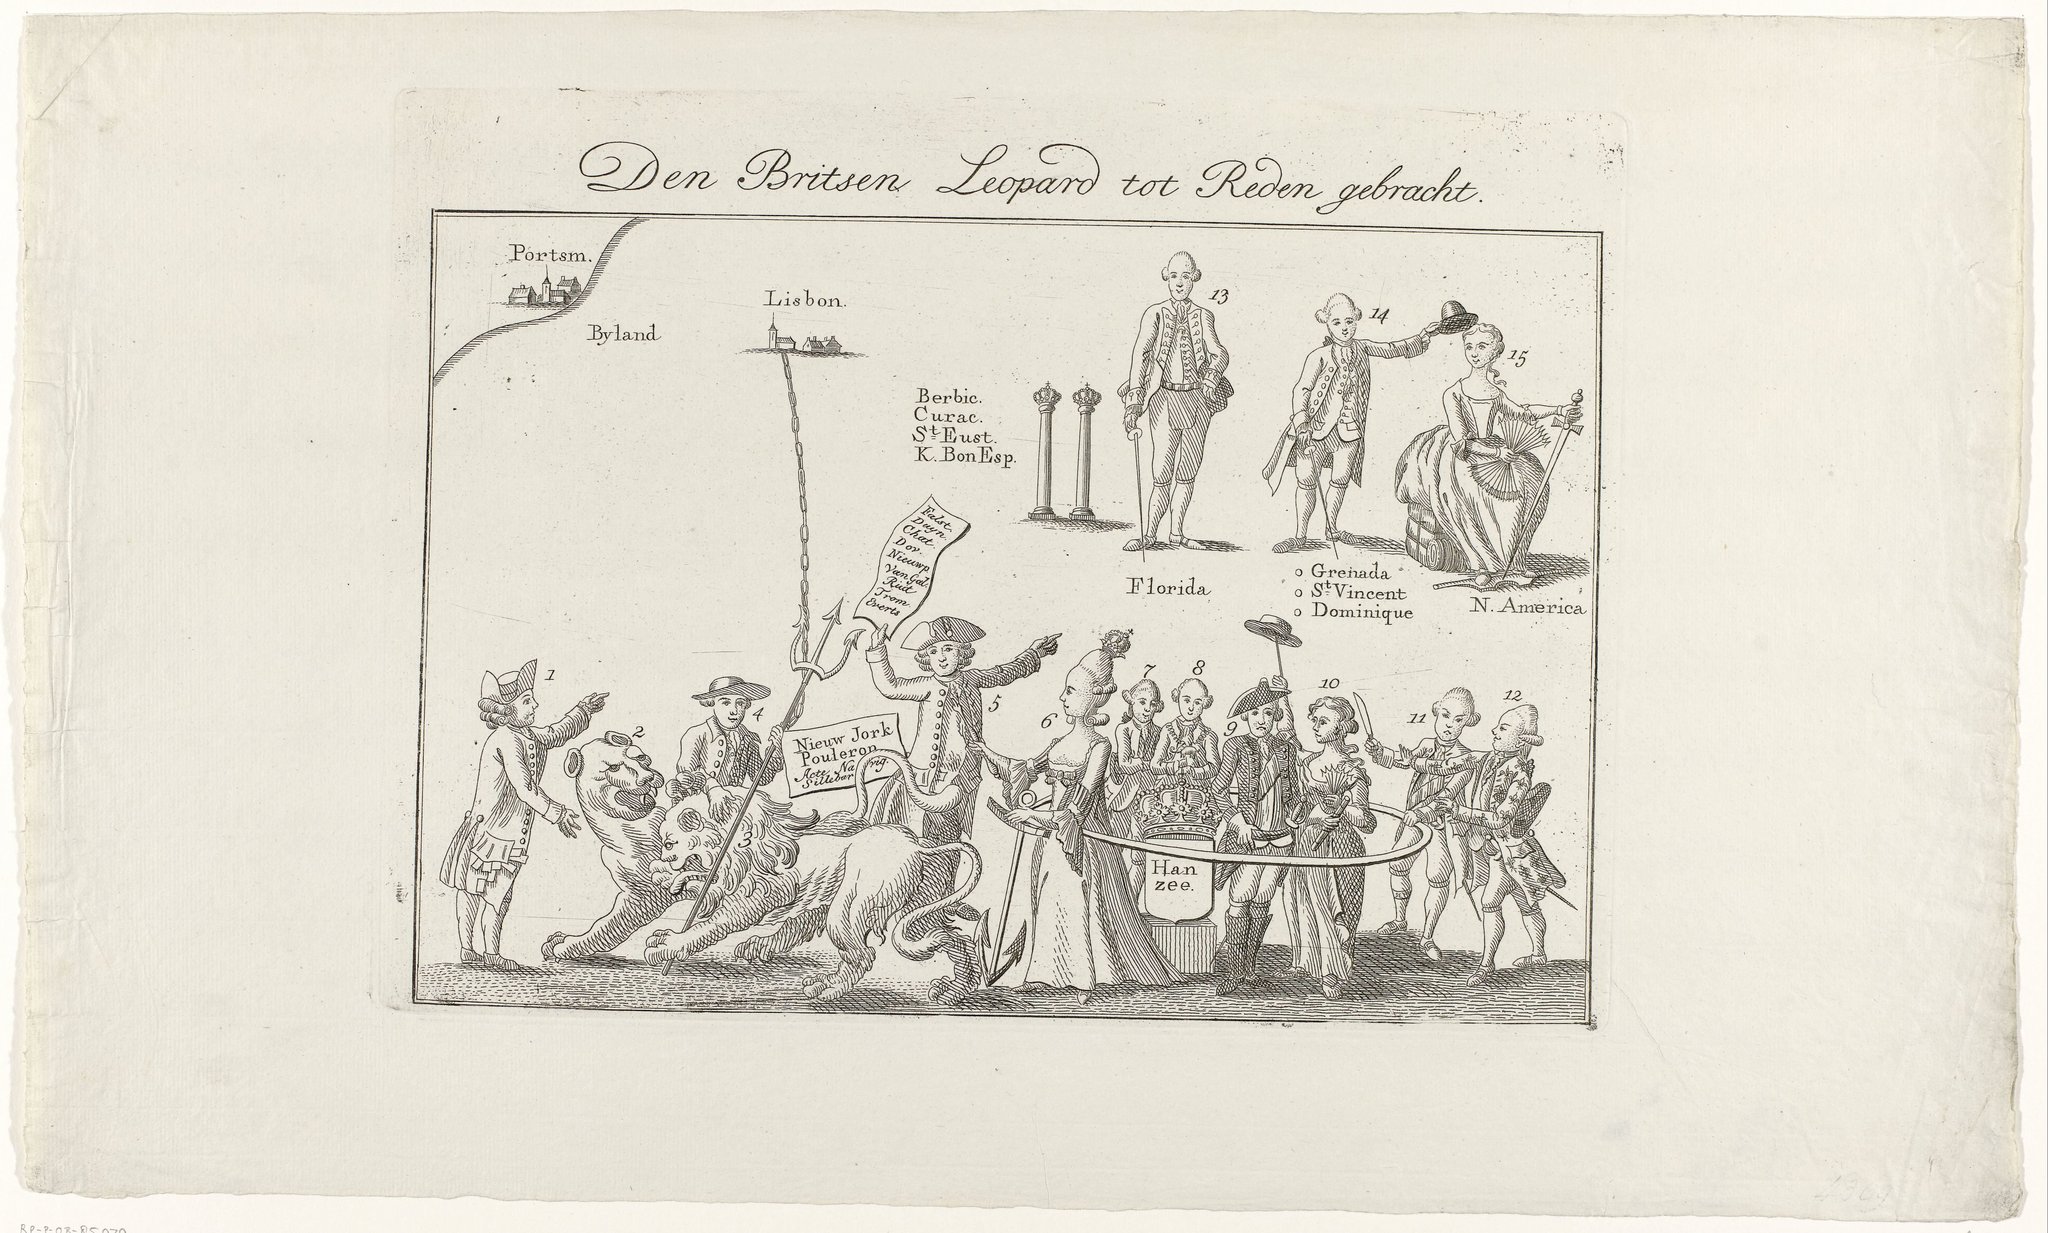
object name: cartoon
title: Britse luipaard en de Nederlandse leeuw, ca. 1780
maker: Anonymous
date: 1780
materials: paper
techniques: etching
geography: northern netherlands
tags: catharina de grote, political caricatures and satires, new york (city), united states of america, fourth anglo-dutch war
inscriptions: collector's mark: Lugt 2228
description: Spotprent op de oorlog tussen de Republiek en Engeland. De Nederlandse Leeuw verdedigt zich enigszins tegen de Britse luipaard. Hierbij Engelsen, de Hollandse koopman en Catharina de Grote met de vorsten verenigd in het het Verbond van Gewapende Neutraliteit. Een Engelsman neemt de leeuw zijn drietand af en heeft een lijst van plaatsen door Engeland veroverd op Nederland, waaronder New York. Op de achtergrond de Spanjaard en de Fransman met de namen van plaatsen veroverde op de Britten, en Amerika. Bij de prent behoren twee losse tekstbladen met verklaringen van de cijfers 1-15 in het Nederlands en Frans.